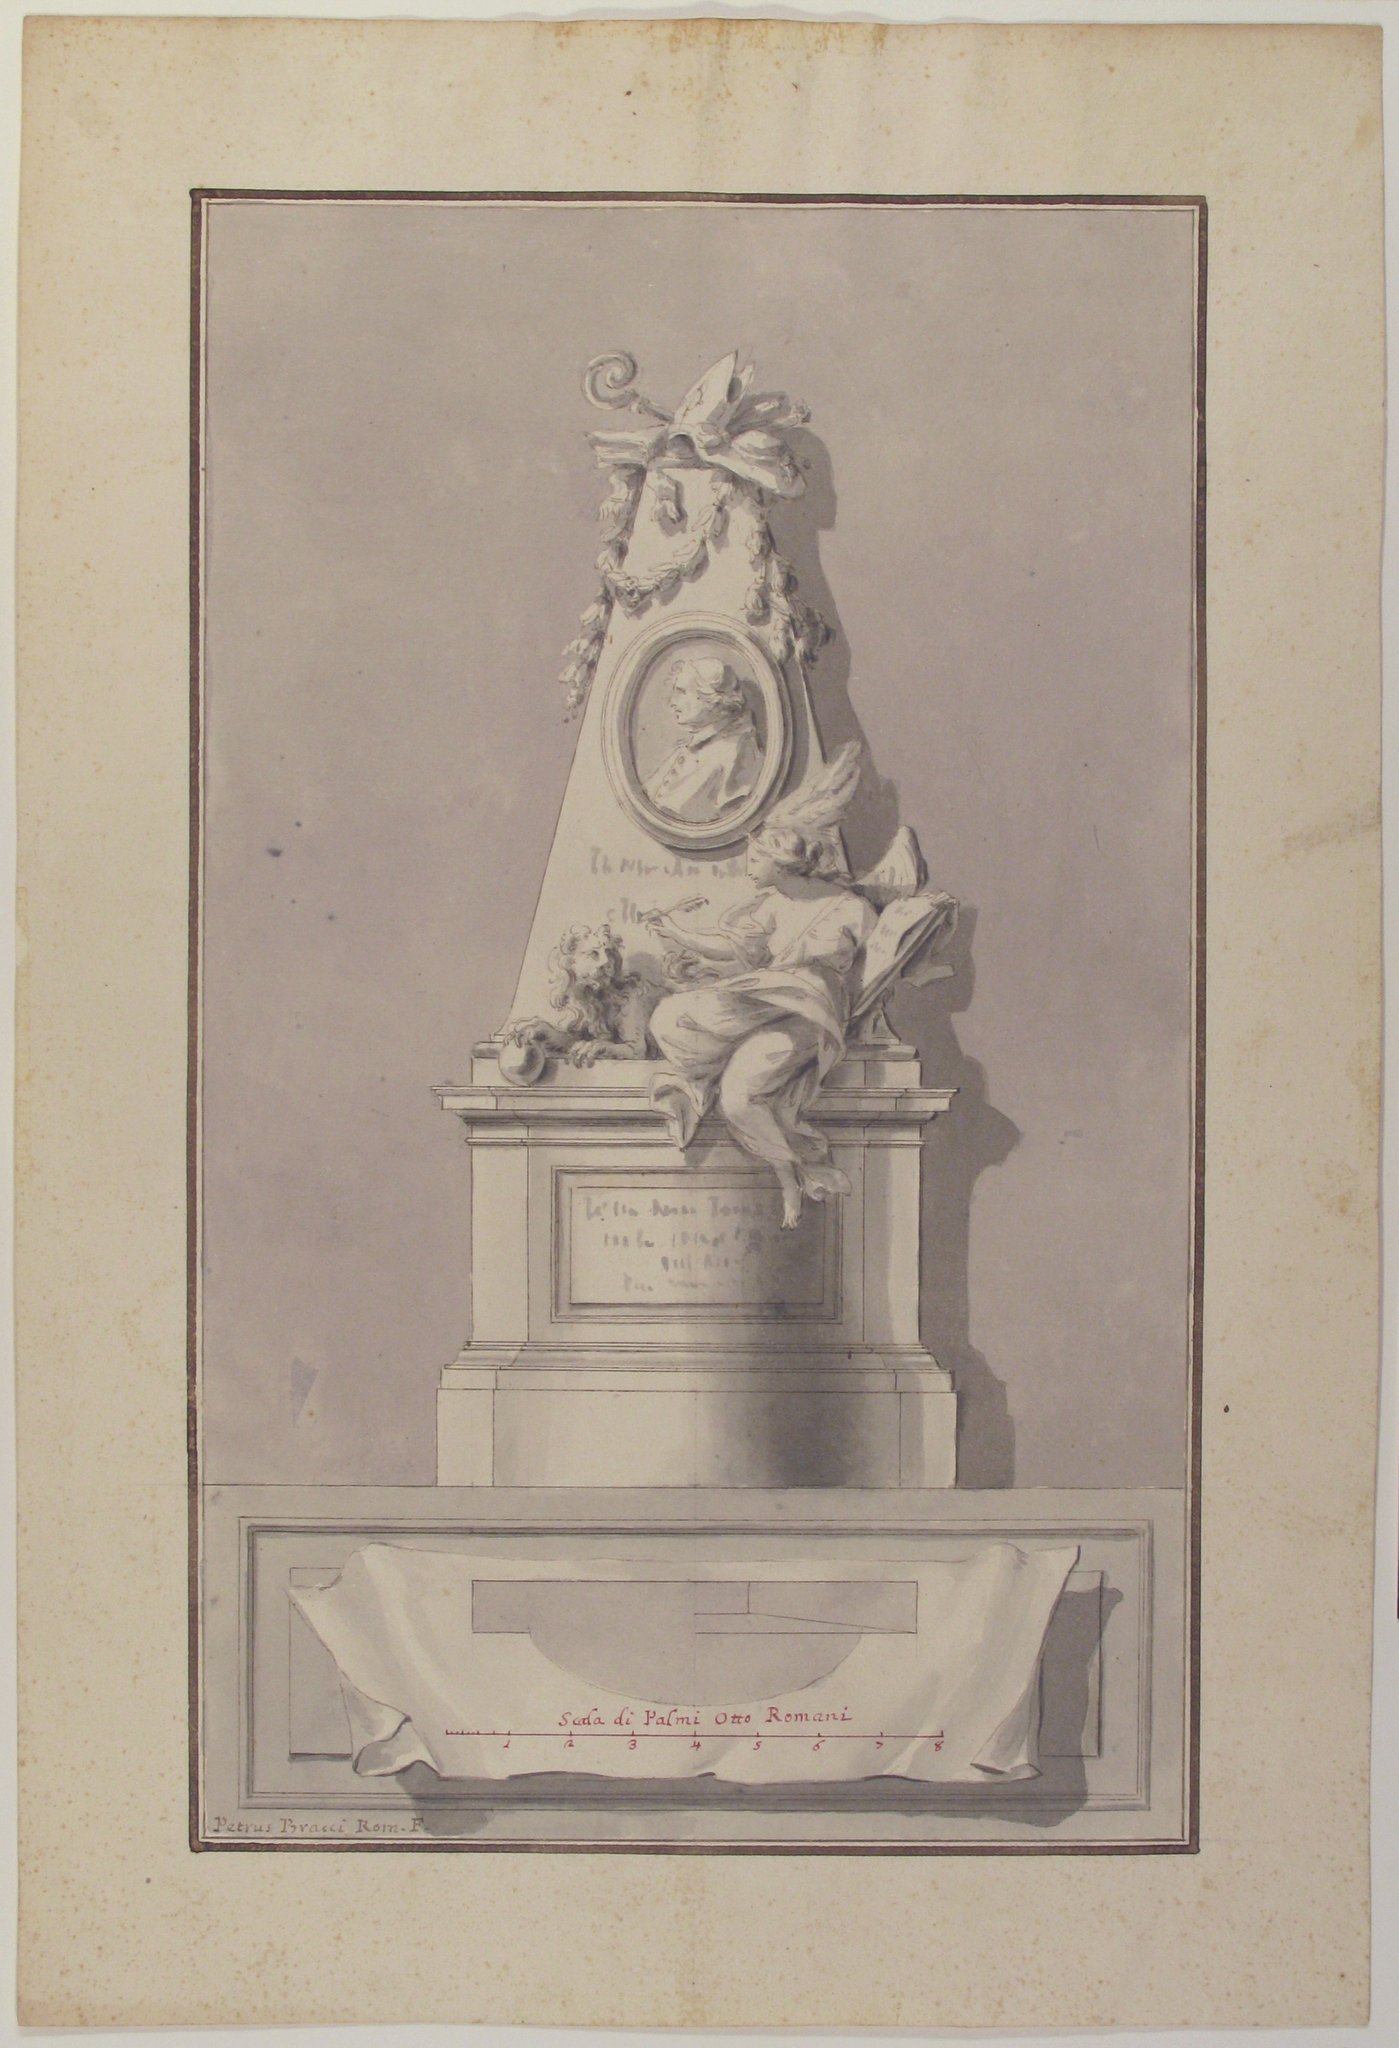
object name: drawing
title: Design for a Tomb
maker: pietro bracci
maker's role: artist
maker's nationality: italian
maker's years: 1700-1773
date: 1700-1773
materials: graphite, ink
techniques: pen, wash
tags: tombs,men,women,lions